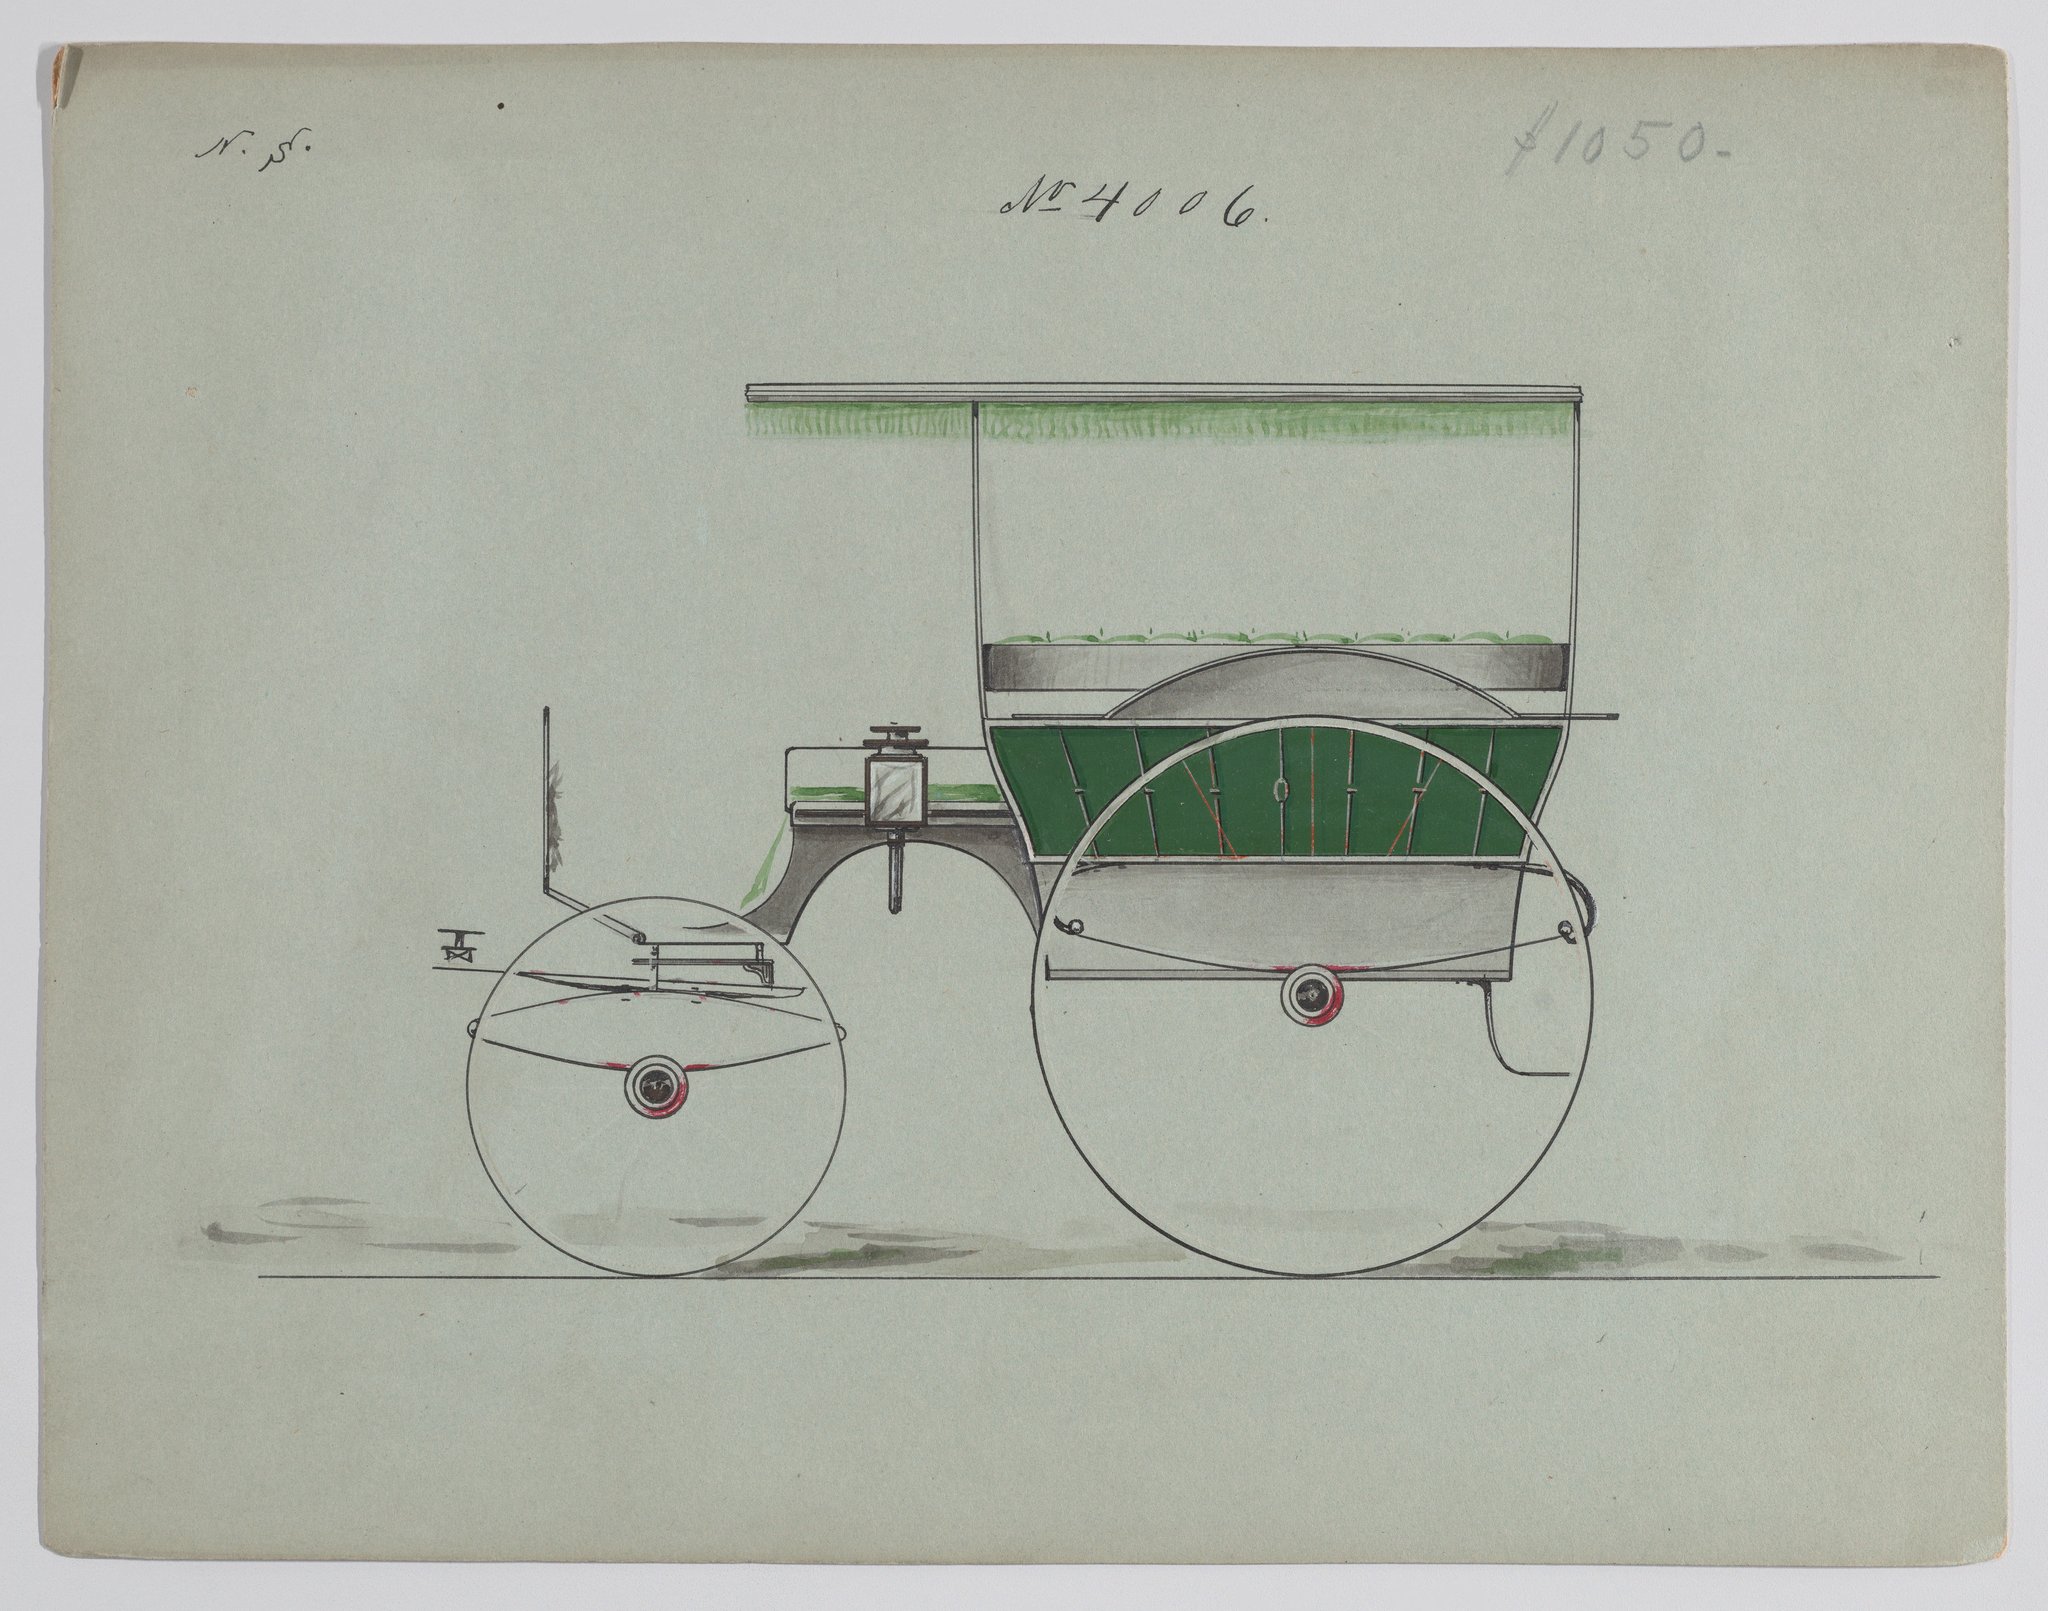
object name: drawing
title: Design for Omnibus or Wagonette, no. 4006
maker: brewster & co.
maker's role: manufacturer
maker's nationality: american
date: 1887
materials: gouache, gum arabic, ink, watercolor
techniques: pen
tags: carriages